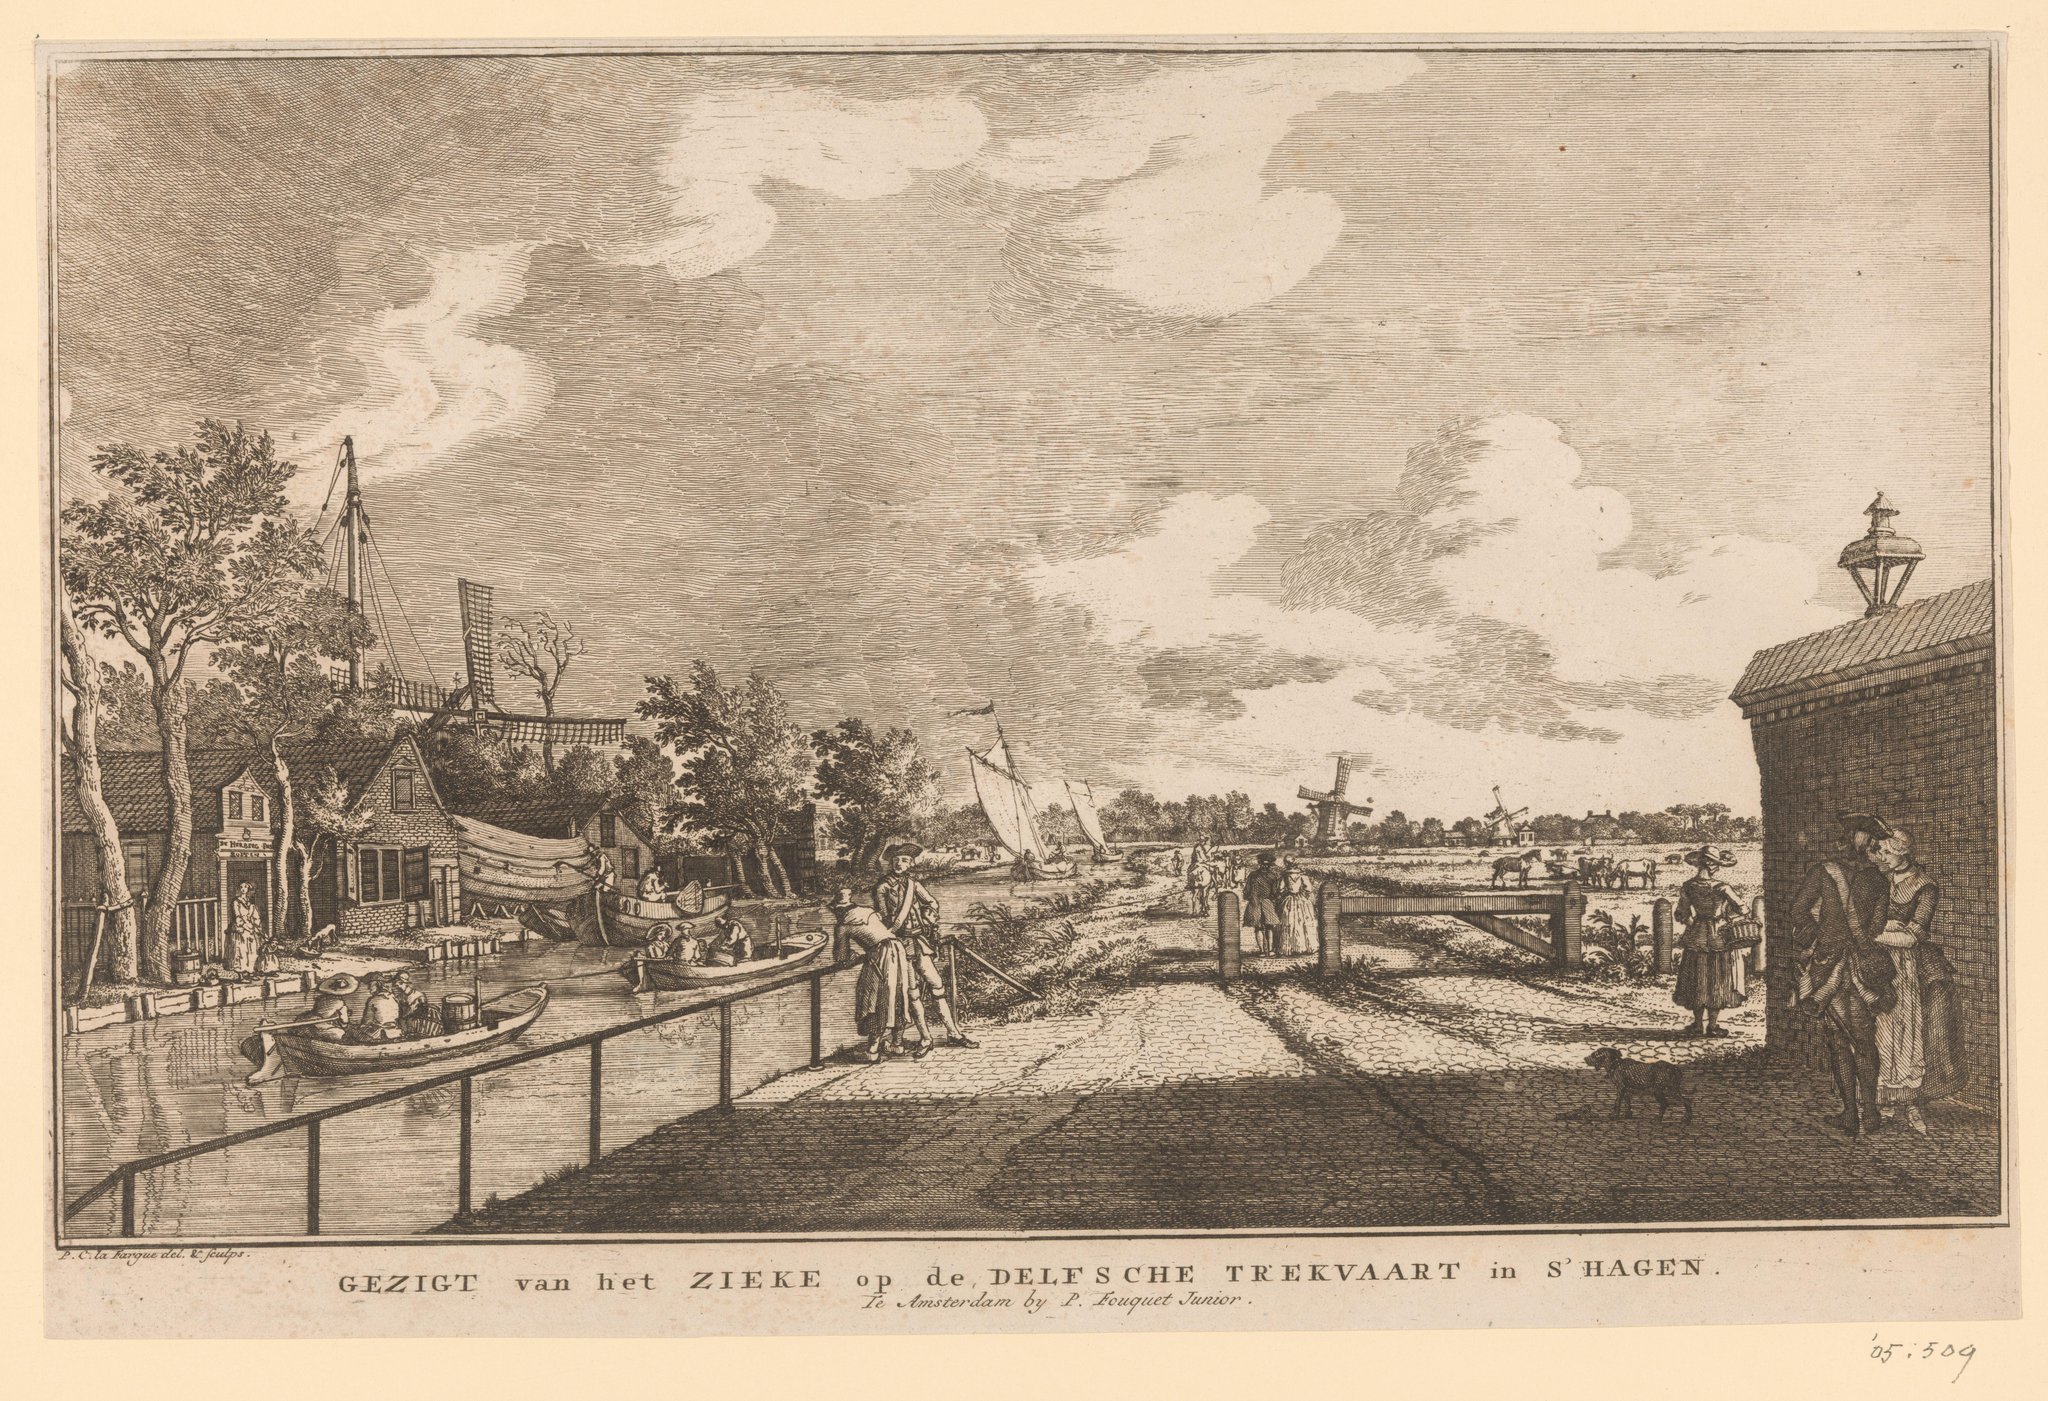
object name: print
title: Gezigt van het Zieke op de Delfsche Trekvaart in 's Hagen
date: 1764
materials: paper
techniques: etching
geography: the hague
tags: city-view, and landscape with man-made constructions, boat propelled by man or animal, the hague, delft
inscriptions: collector's mark: Lugt 2228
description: Gezicht op de Trekweg en Trekvliet richting Delft te Den Haag, gezien vanaf het Zieken bij het latere Rijswijkseplein (rechts).